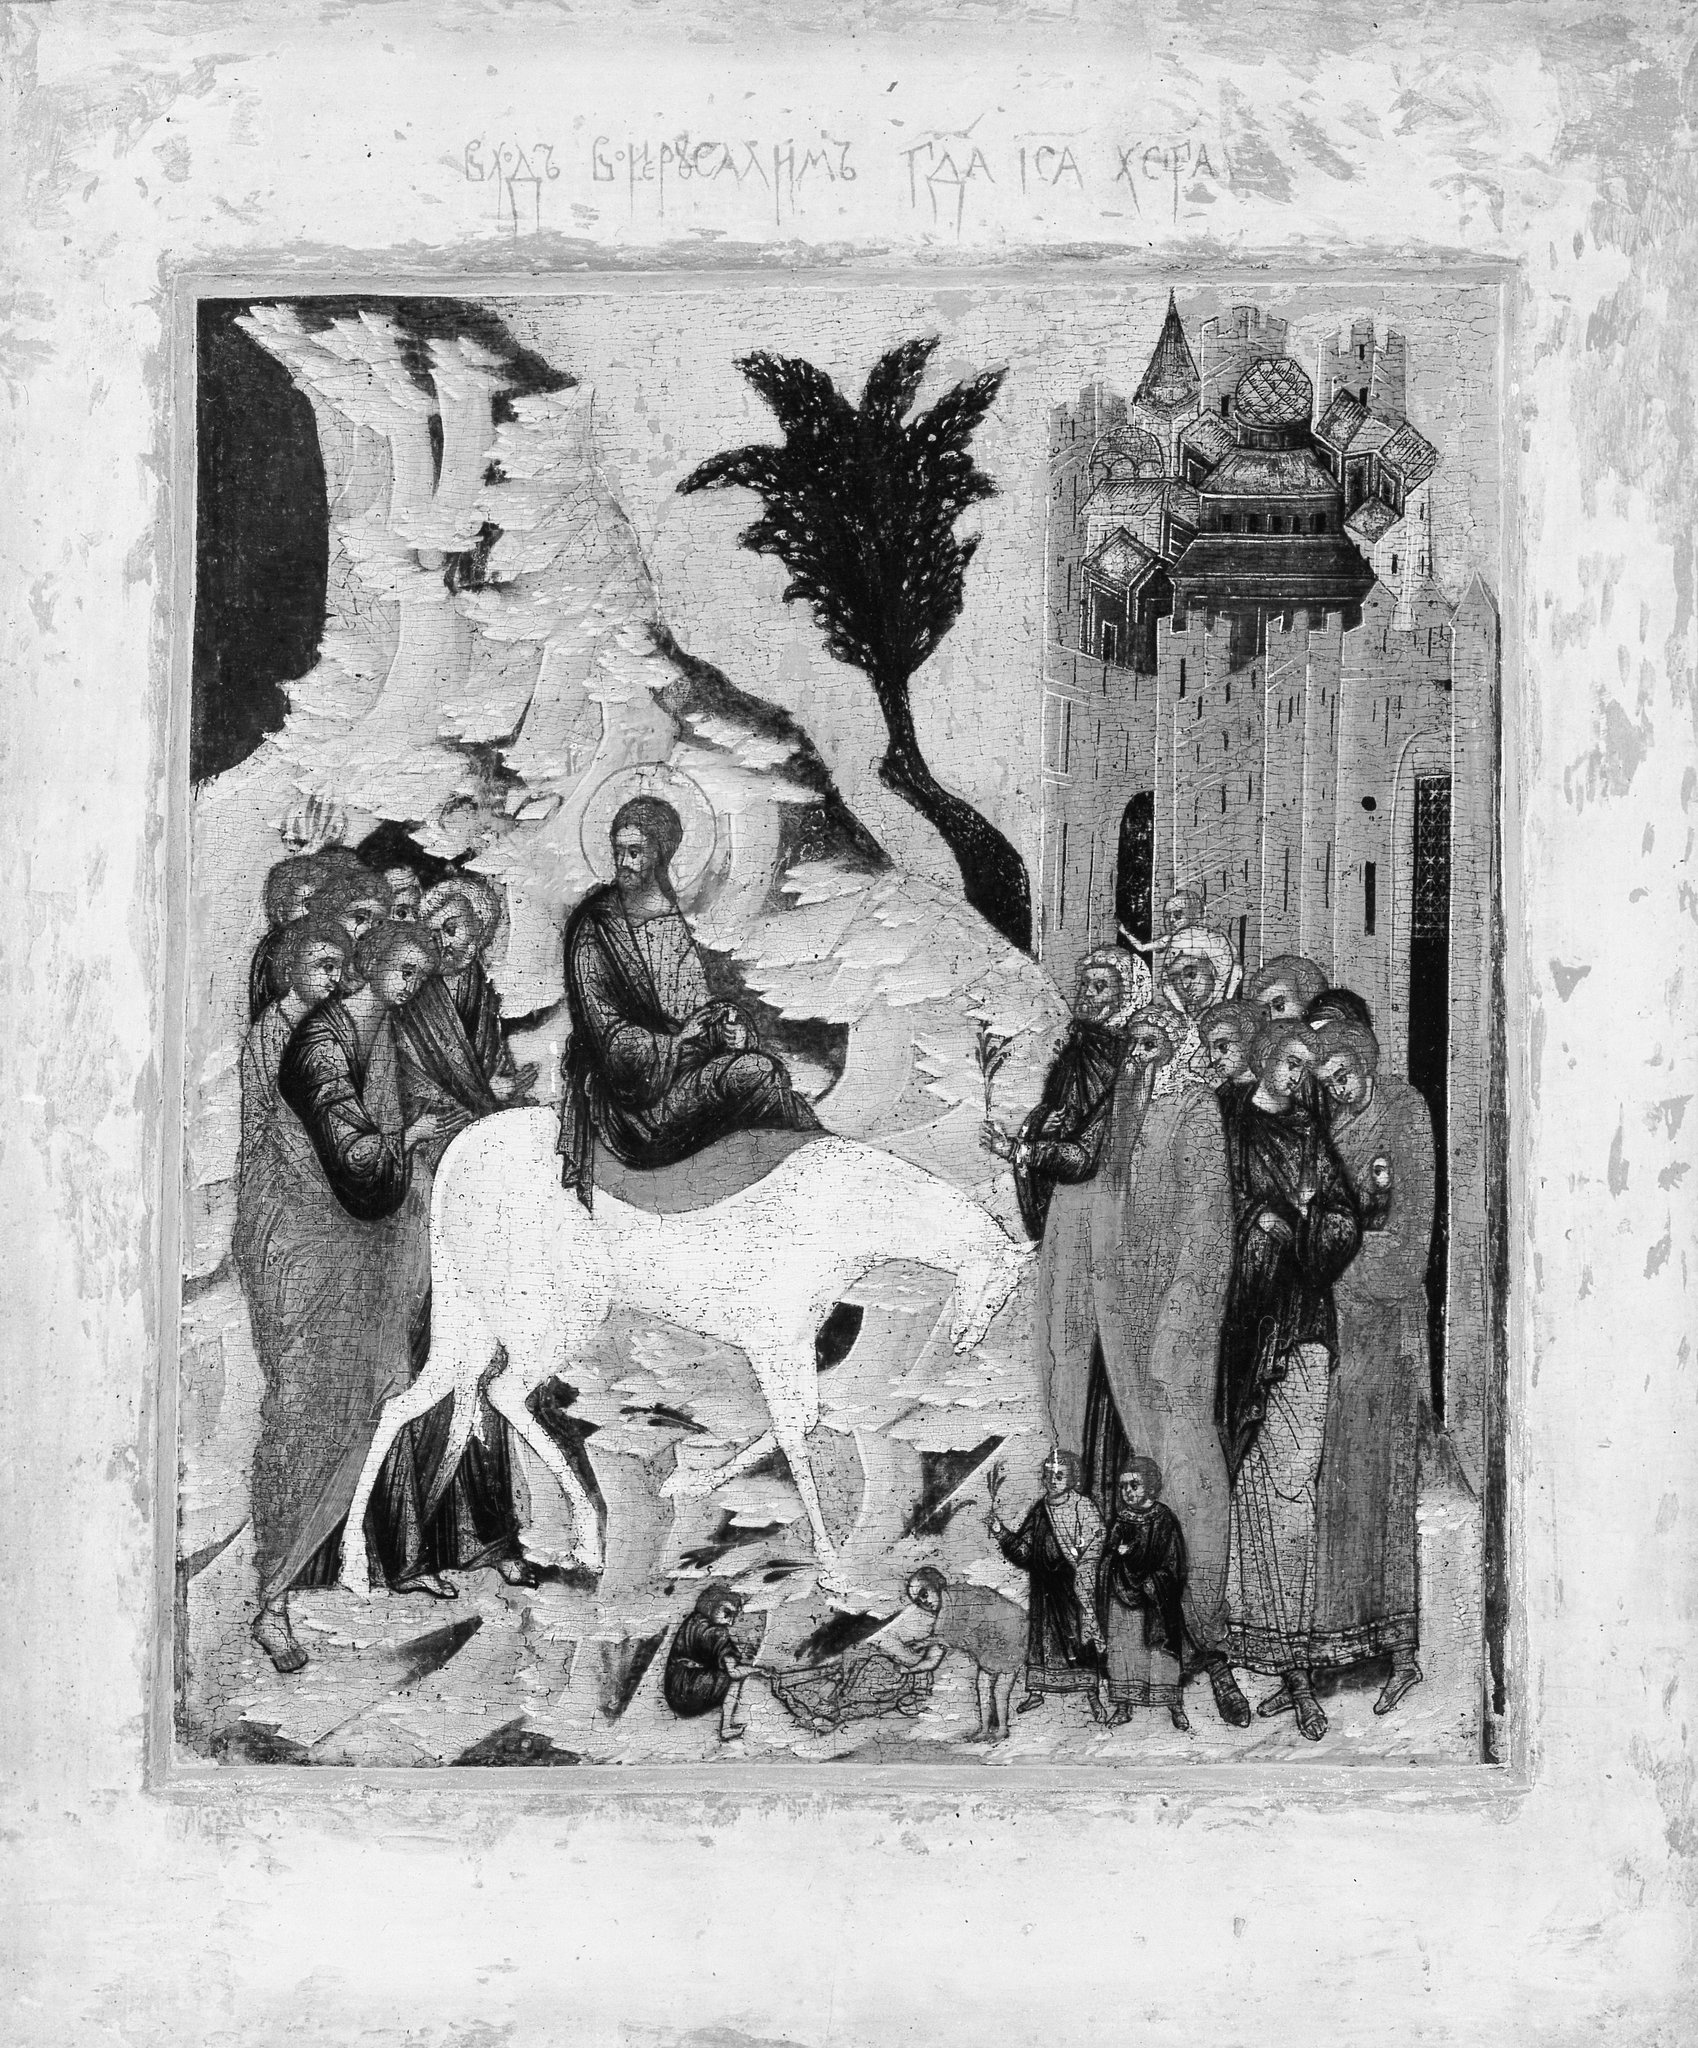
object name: painting, icon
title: Christ's Entry into Jerusalem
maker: russian painter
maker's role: artist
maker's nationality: russian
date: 1600-1699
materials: paint, wood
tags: men,horses,christ